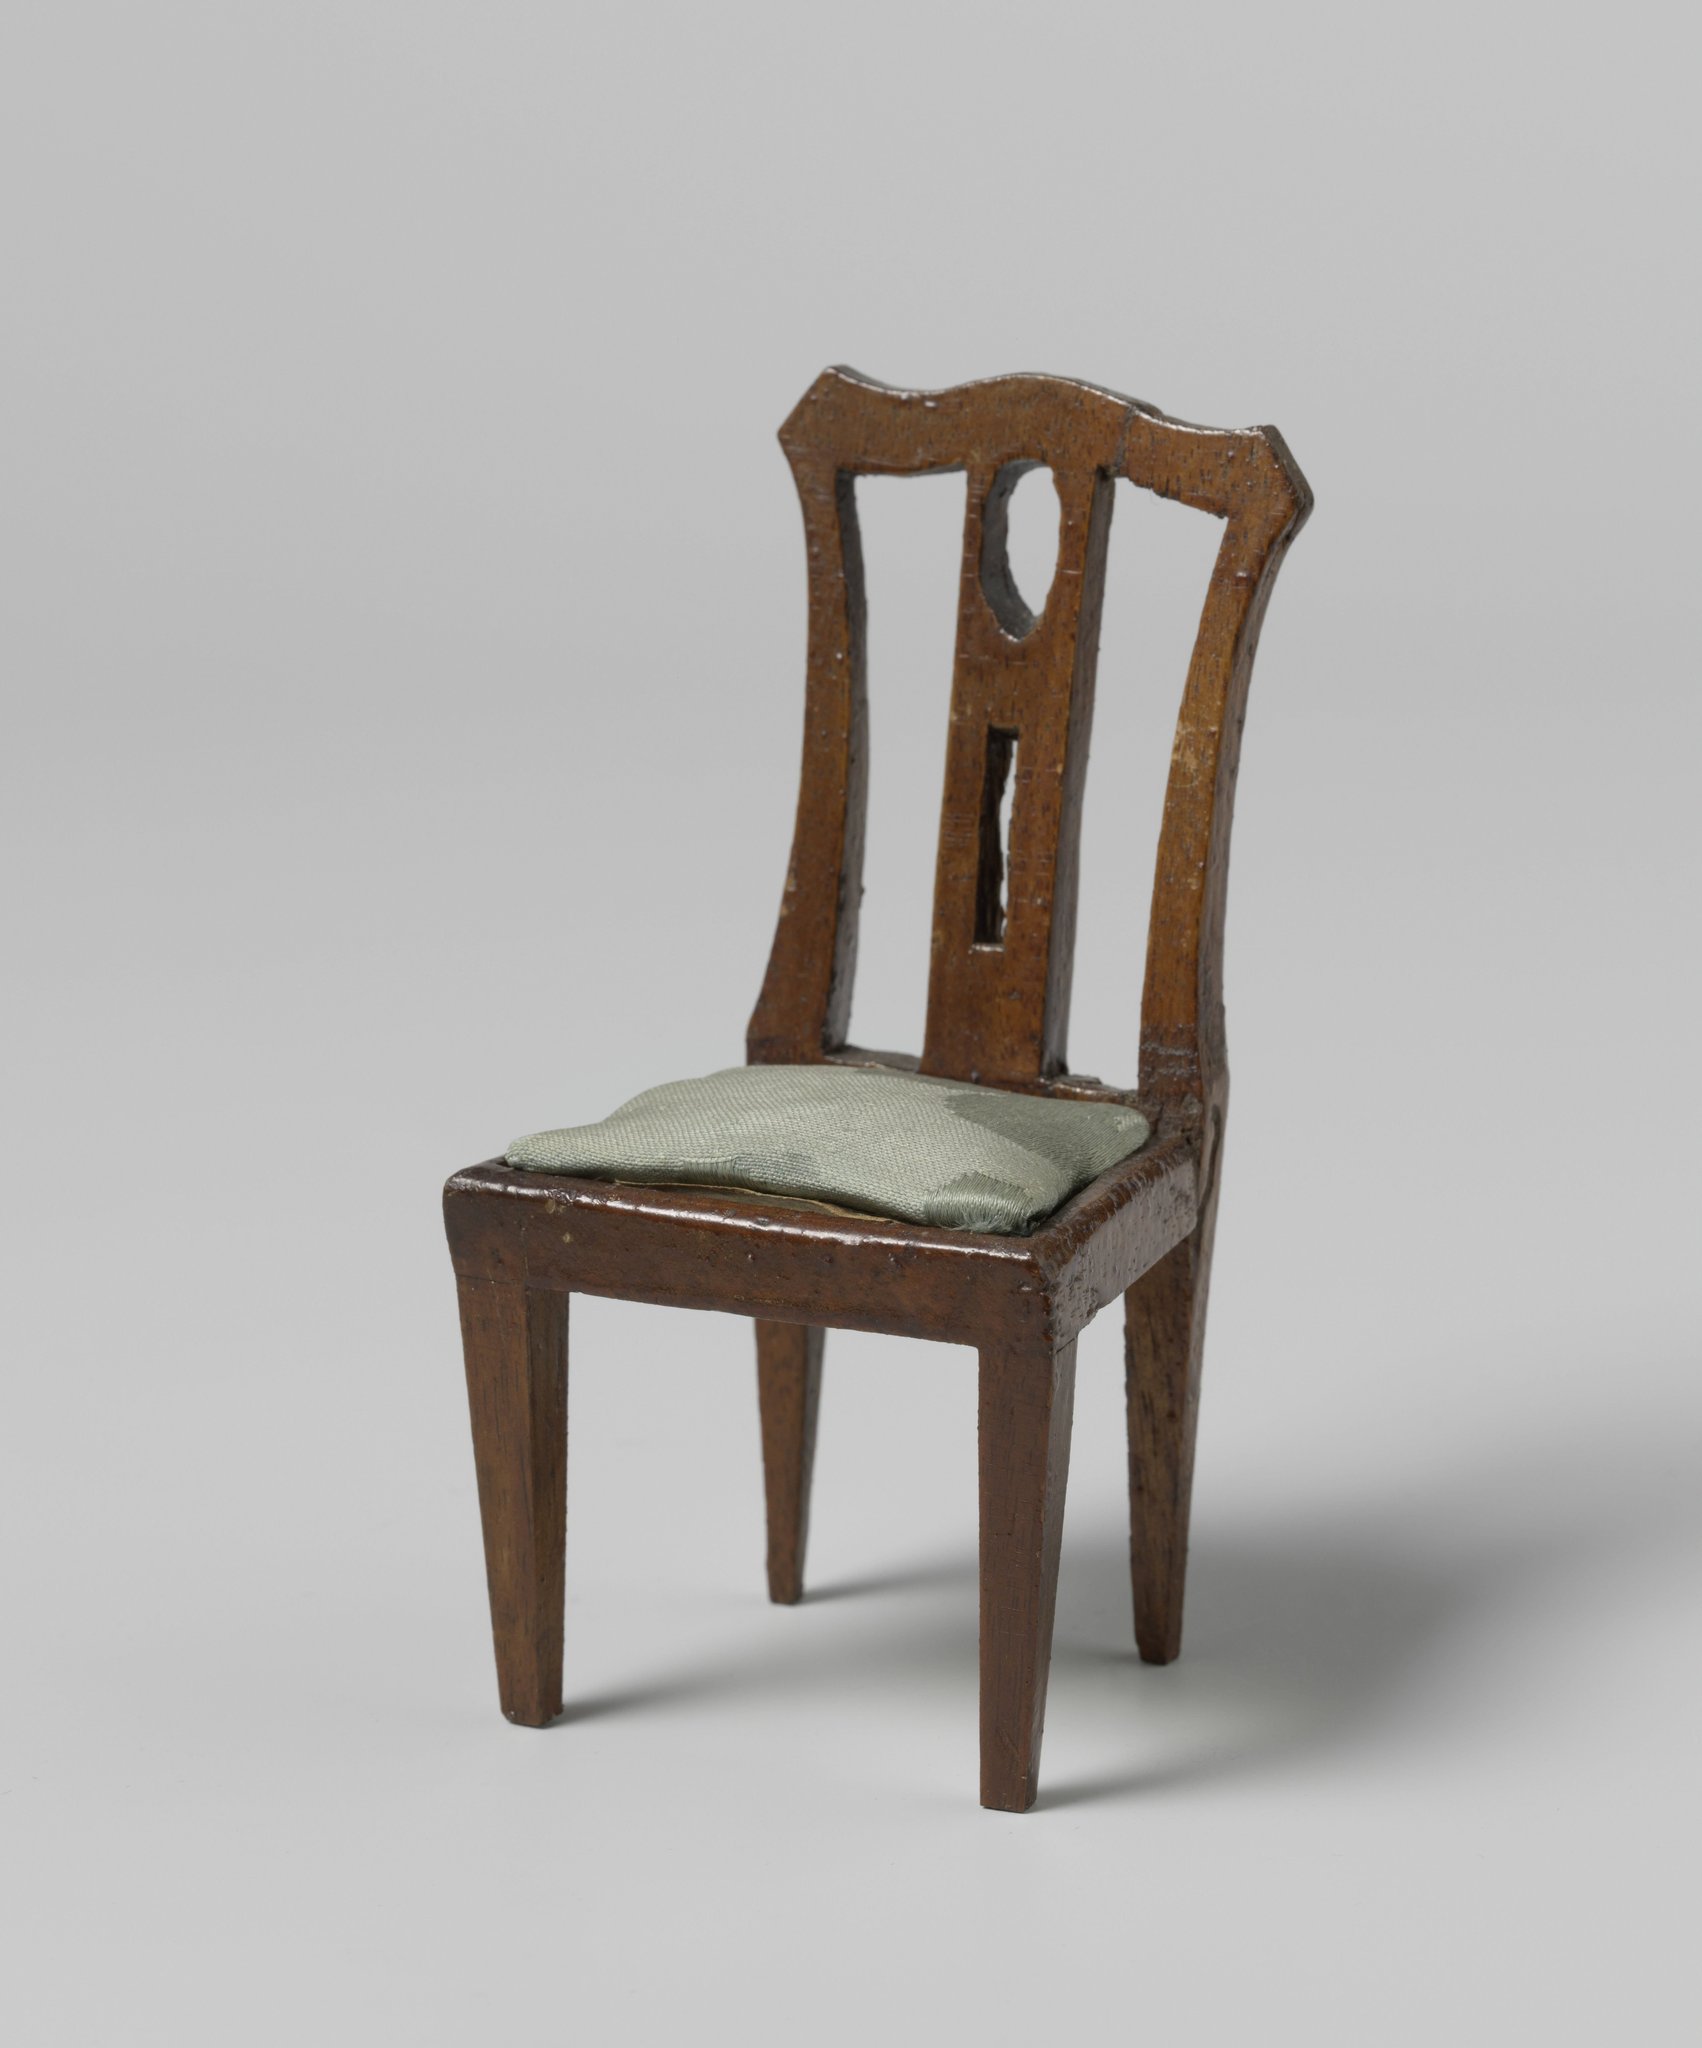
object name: chair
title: Stoel met blauwe bekleding en rechte rug met opengewerkte middenstijl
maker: Anonymous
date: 1775-1800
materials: cardboard, wood, paper, silk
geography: amsterdam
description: Stoel van mahoniehout met een rechte rug, rechte opengewerkte middenstijl en strakke taps toelopende poten. De losse zitting is bekleed met blauwe zijden damast.